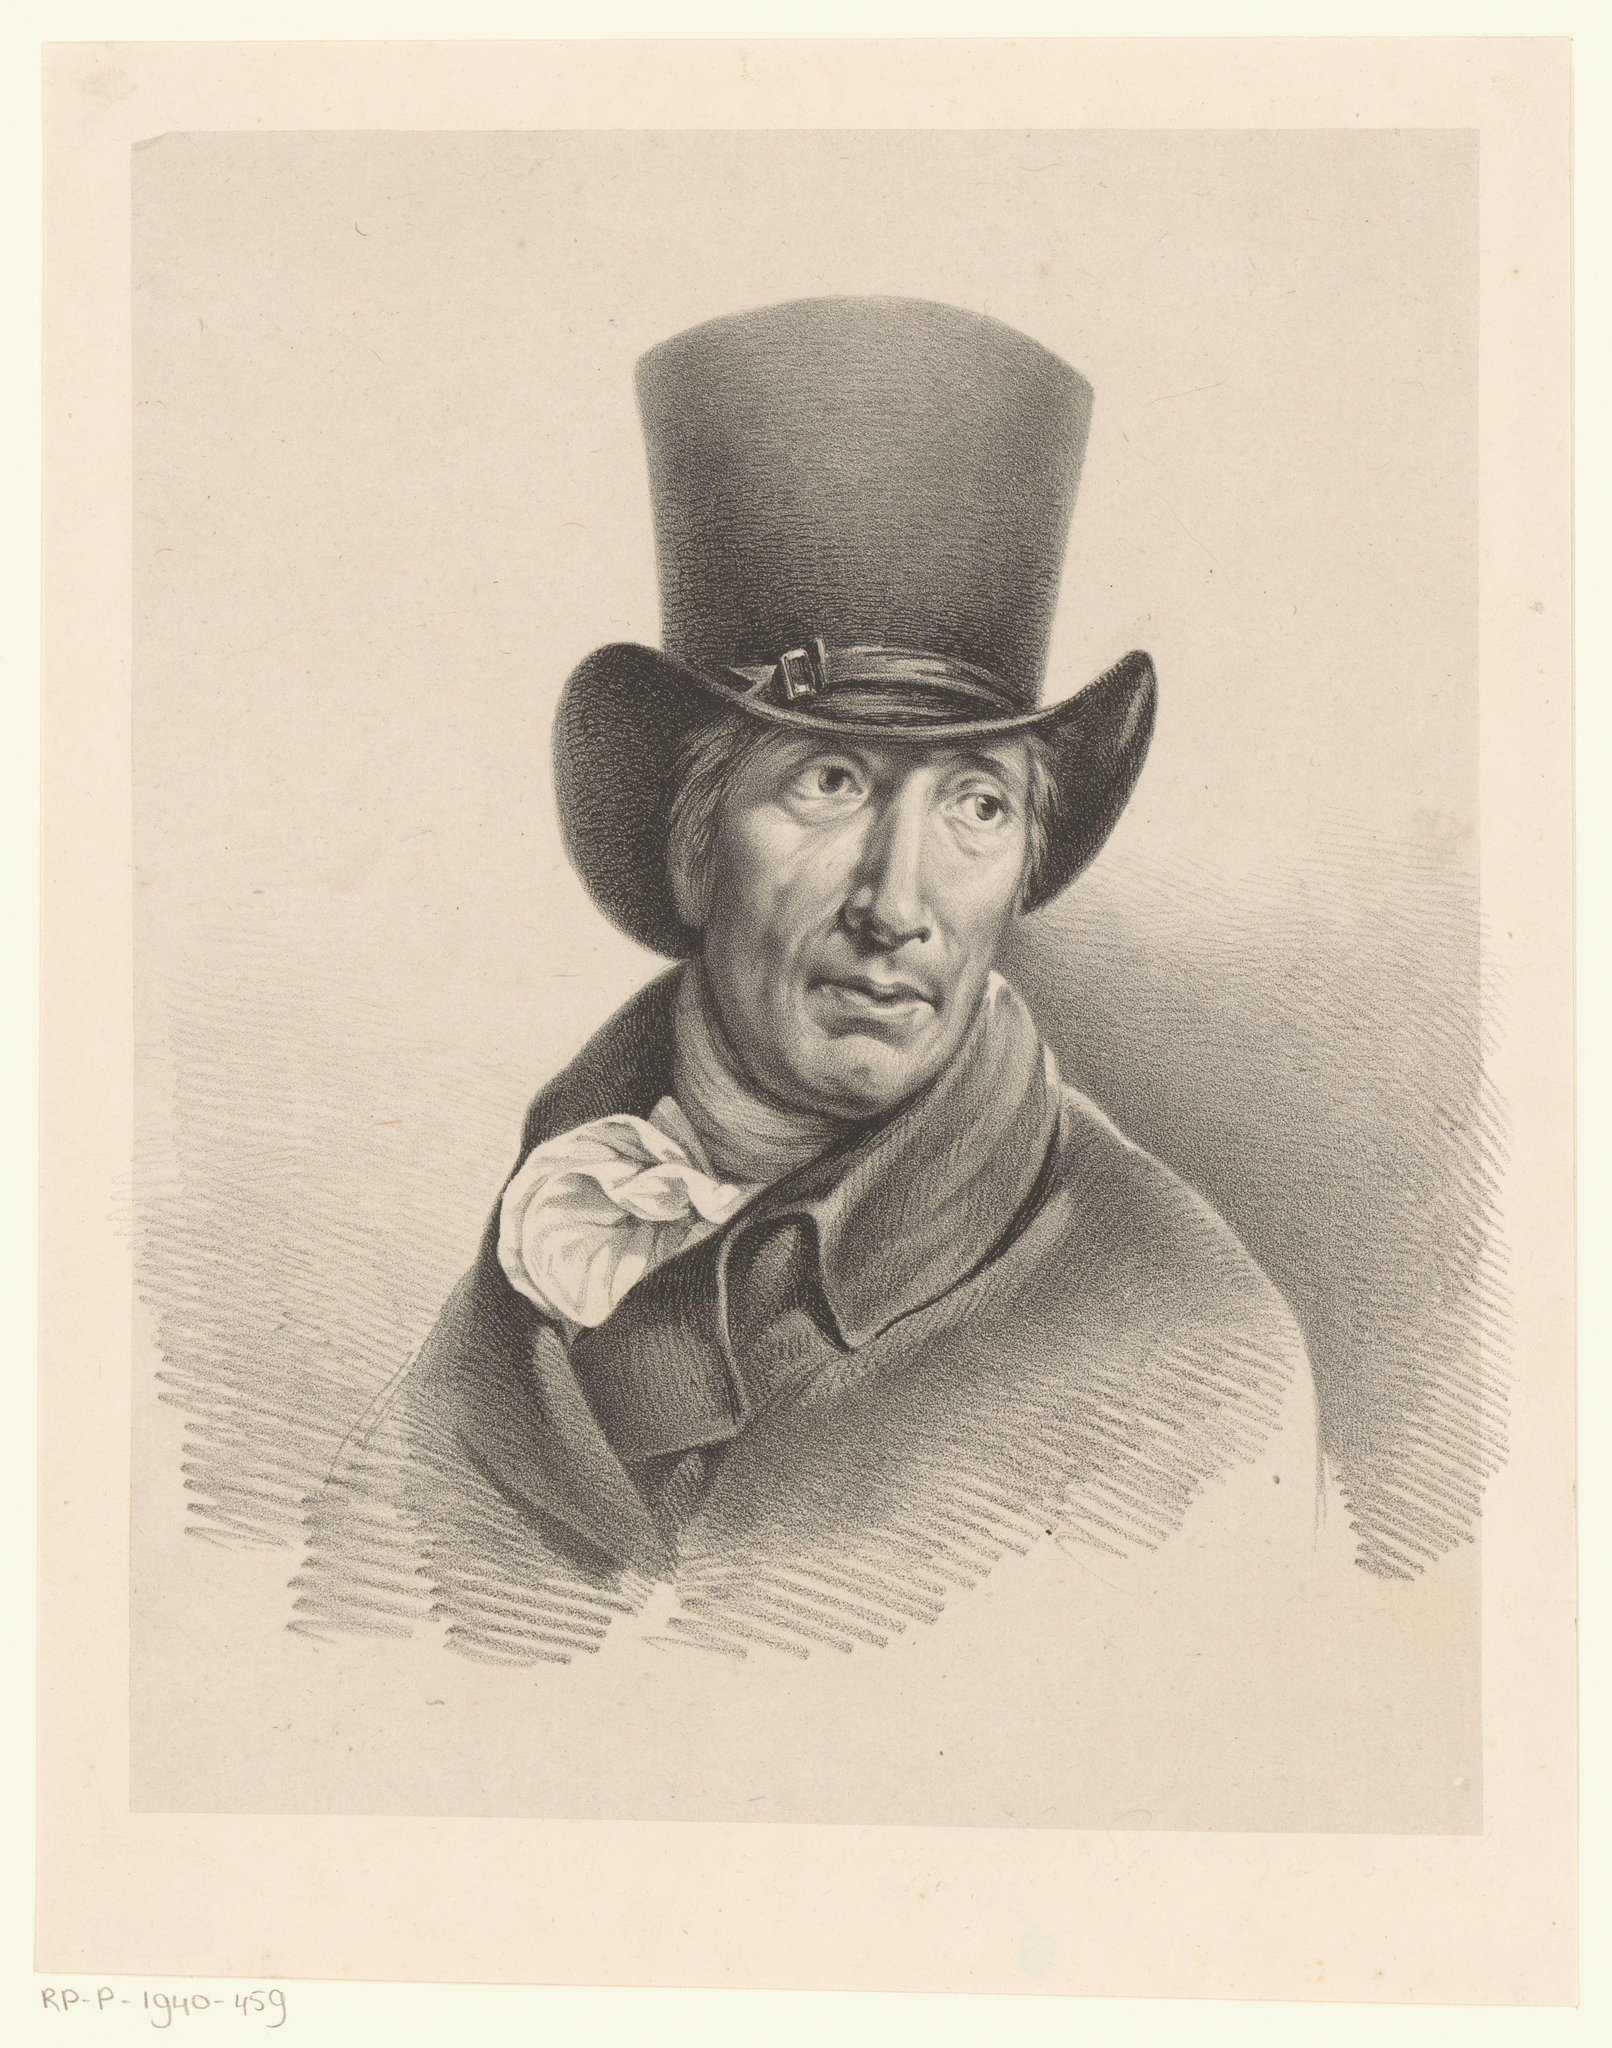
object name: print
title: Portret van Pieter Pietersz Barbiers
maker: joannes willem vos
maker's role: print maker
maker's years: 1806-1853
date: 1816-1853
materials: paper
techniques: lithograph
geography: netherlands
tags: amsterdam, draughtsman, pieter pietersz. barbiers, historical persons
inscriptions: collector's mark: Lugt 2760, collector's mark: Lugt 2228